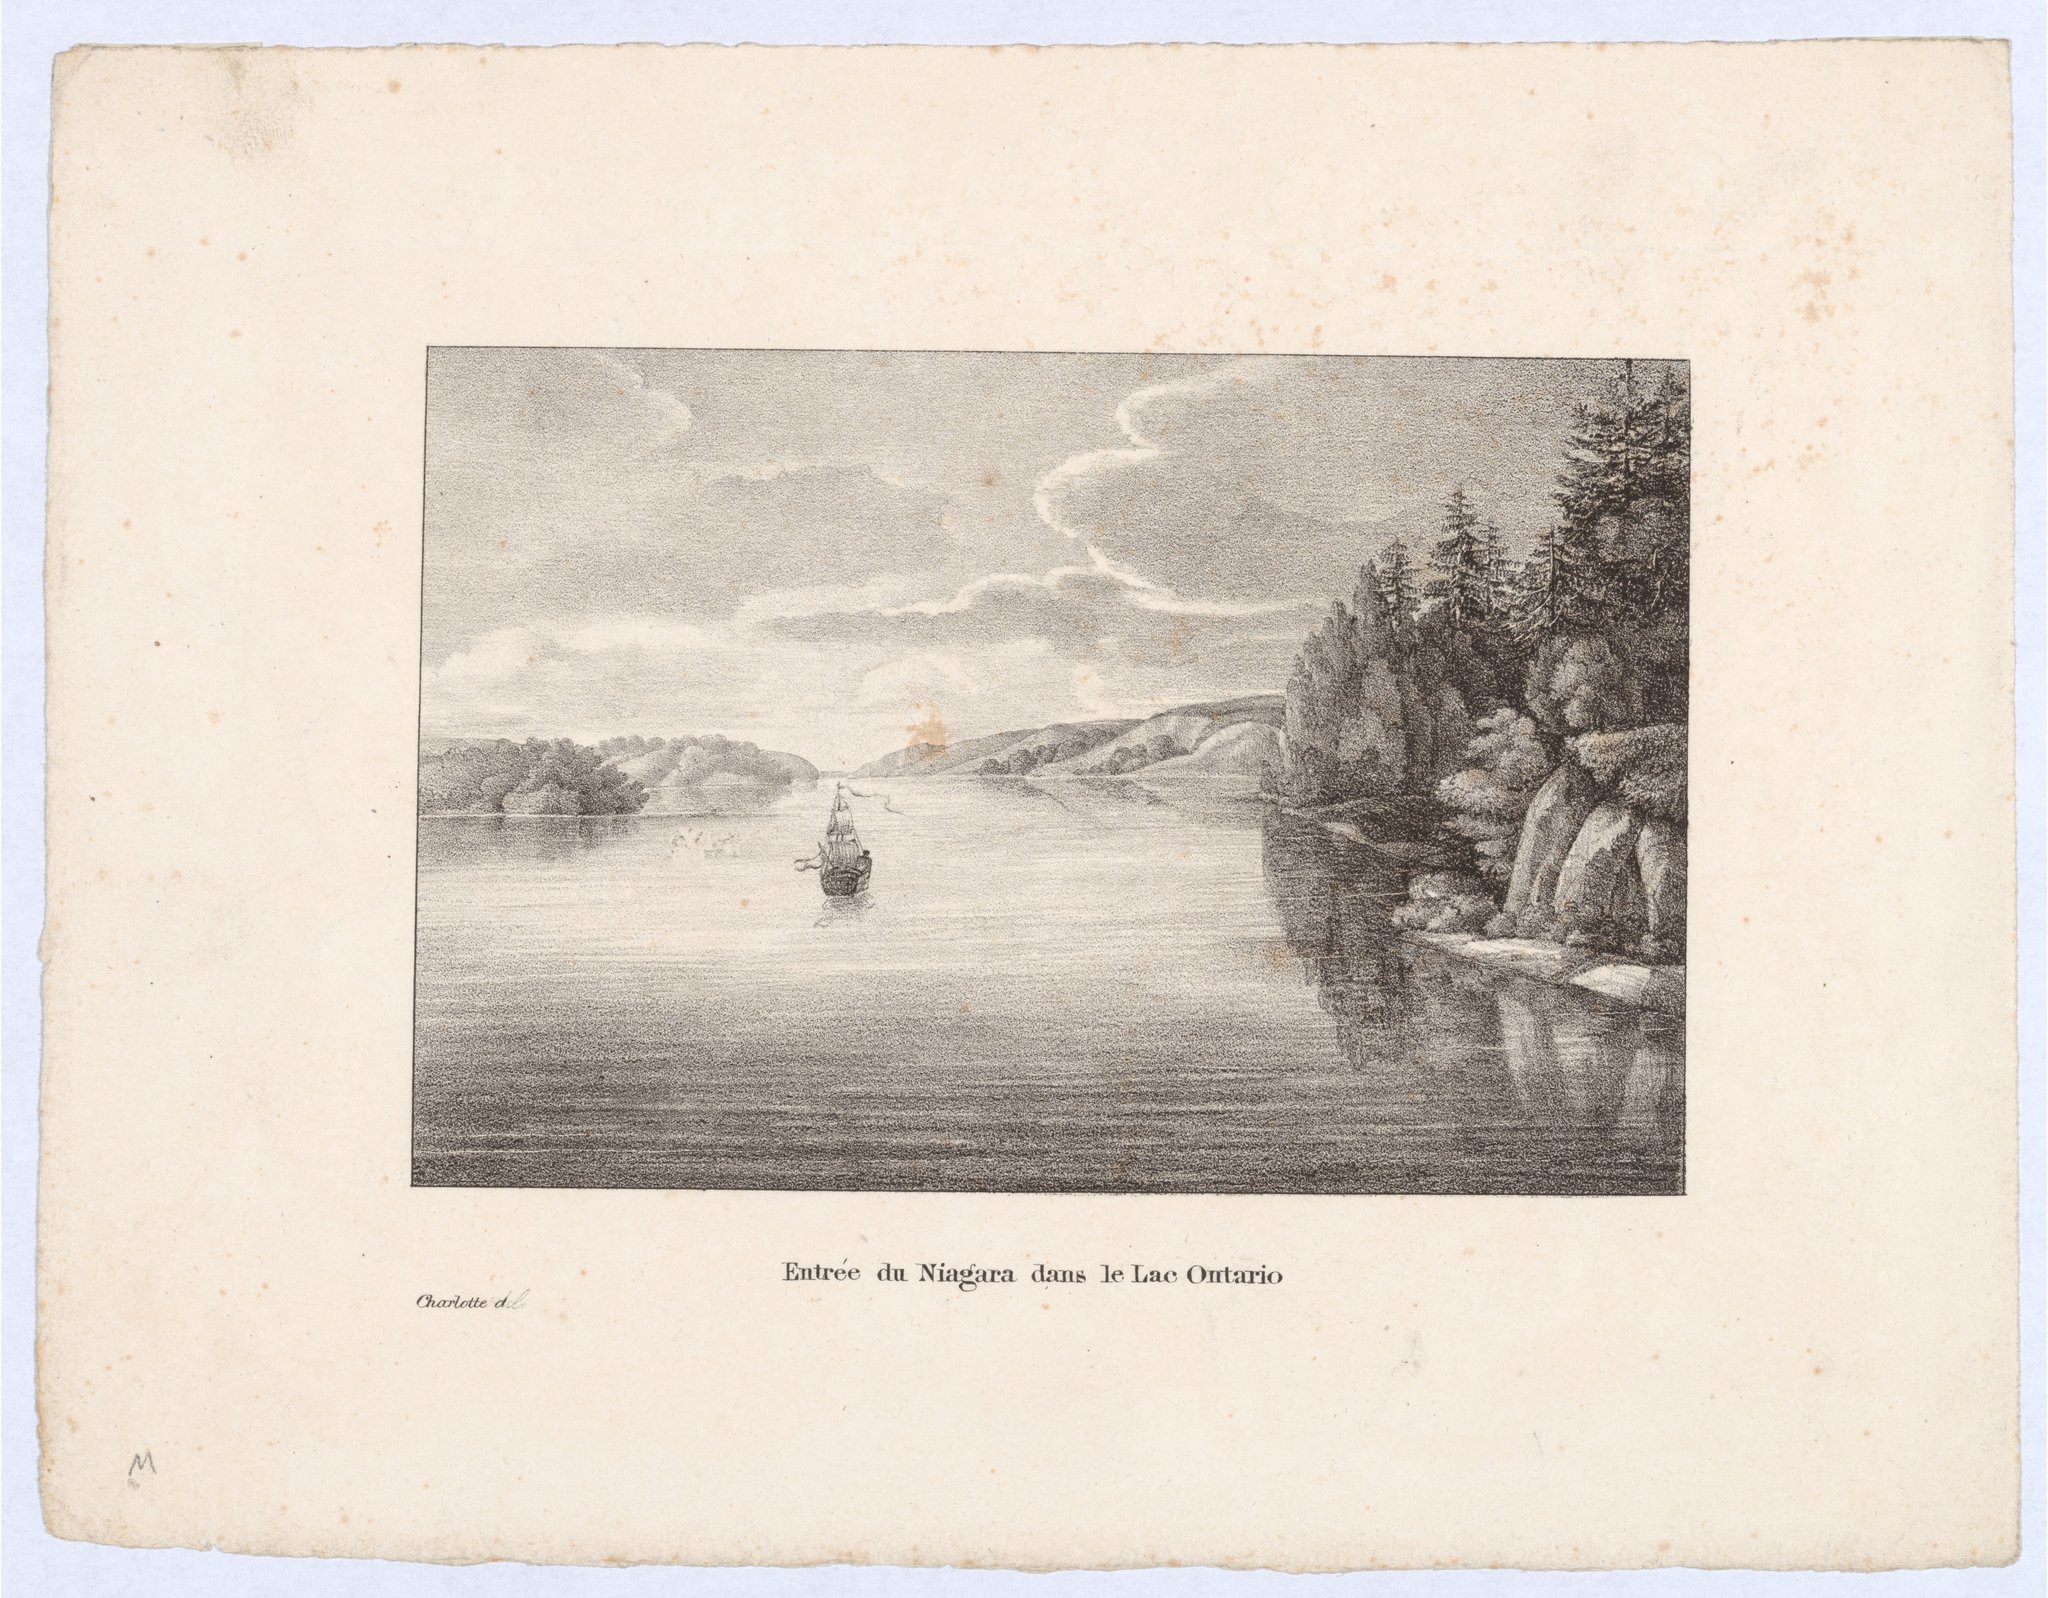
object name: print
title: Entrée du Niagara dans le Lac Ontario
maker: charlotte bonaparte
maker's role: artist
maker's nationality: french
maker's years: 1802-1839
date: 1824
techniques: lithograph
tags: lakes,boats